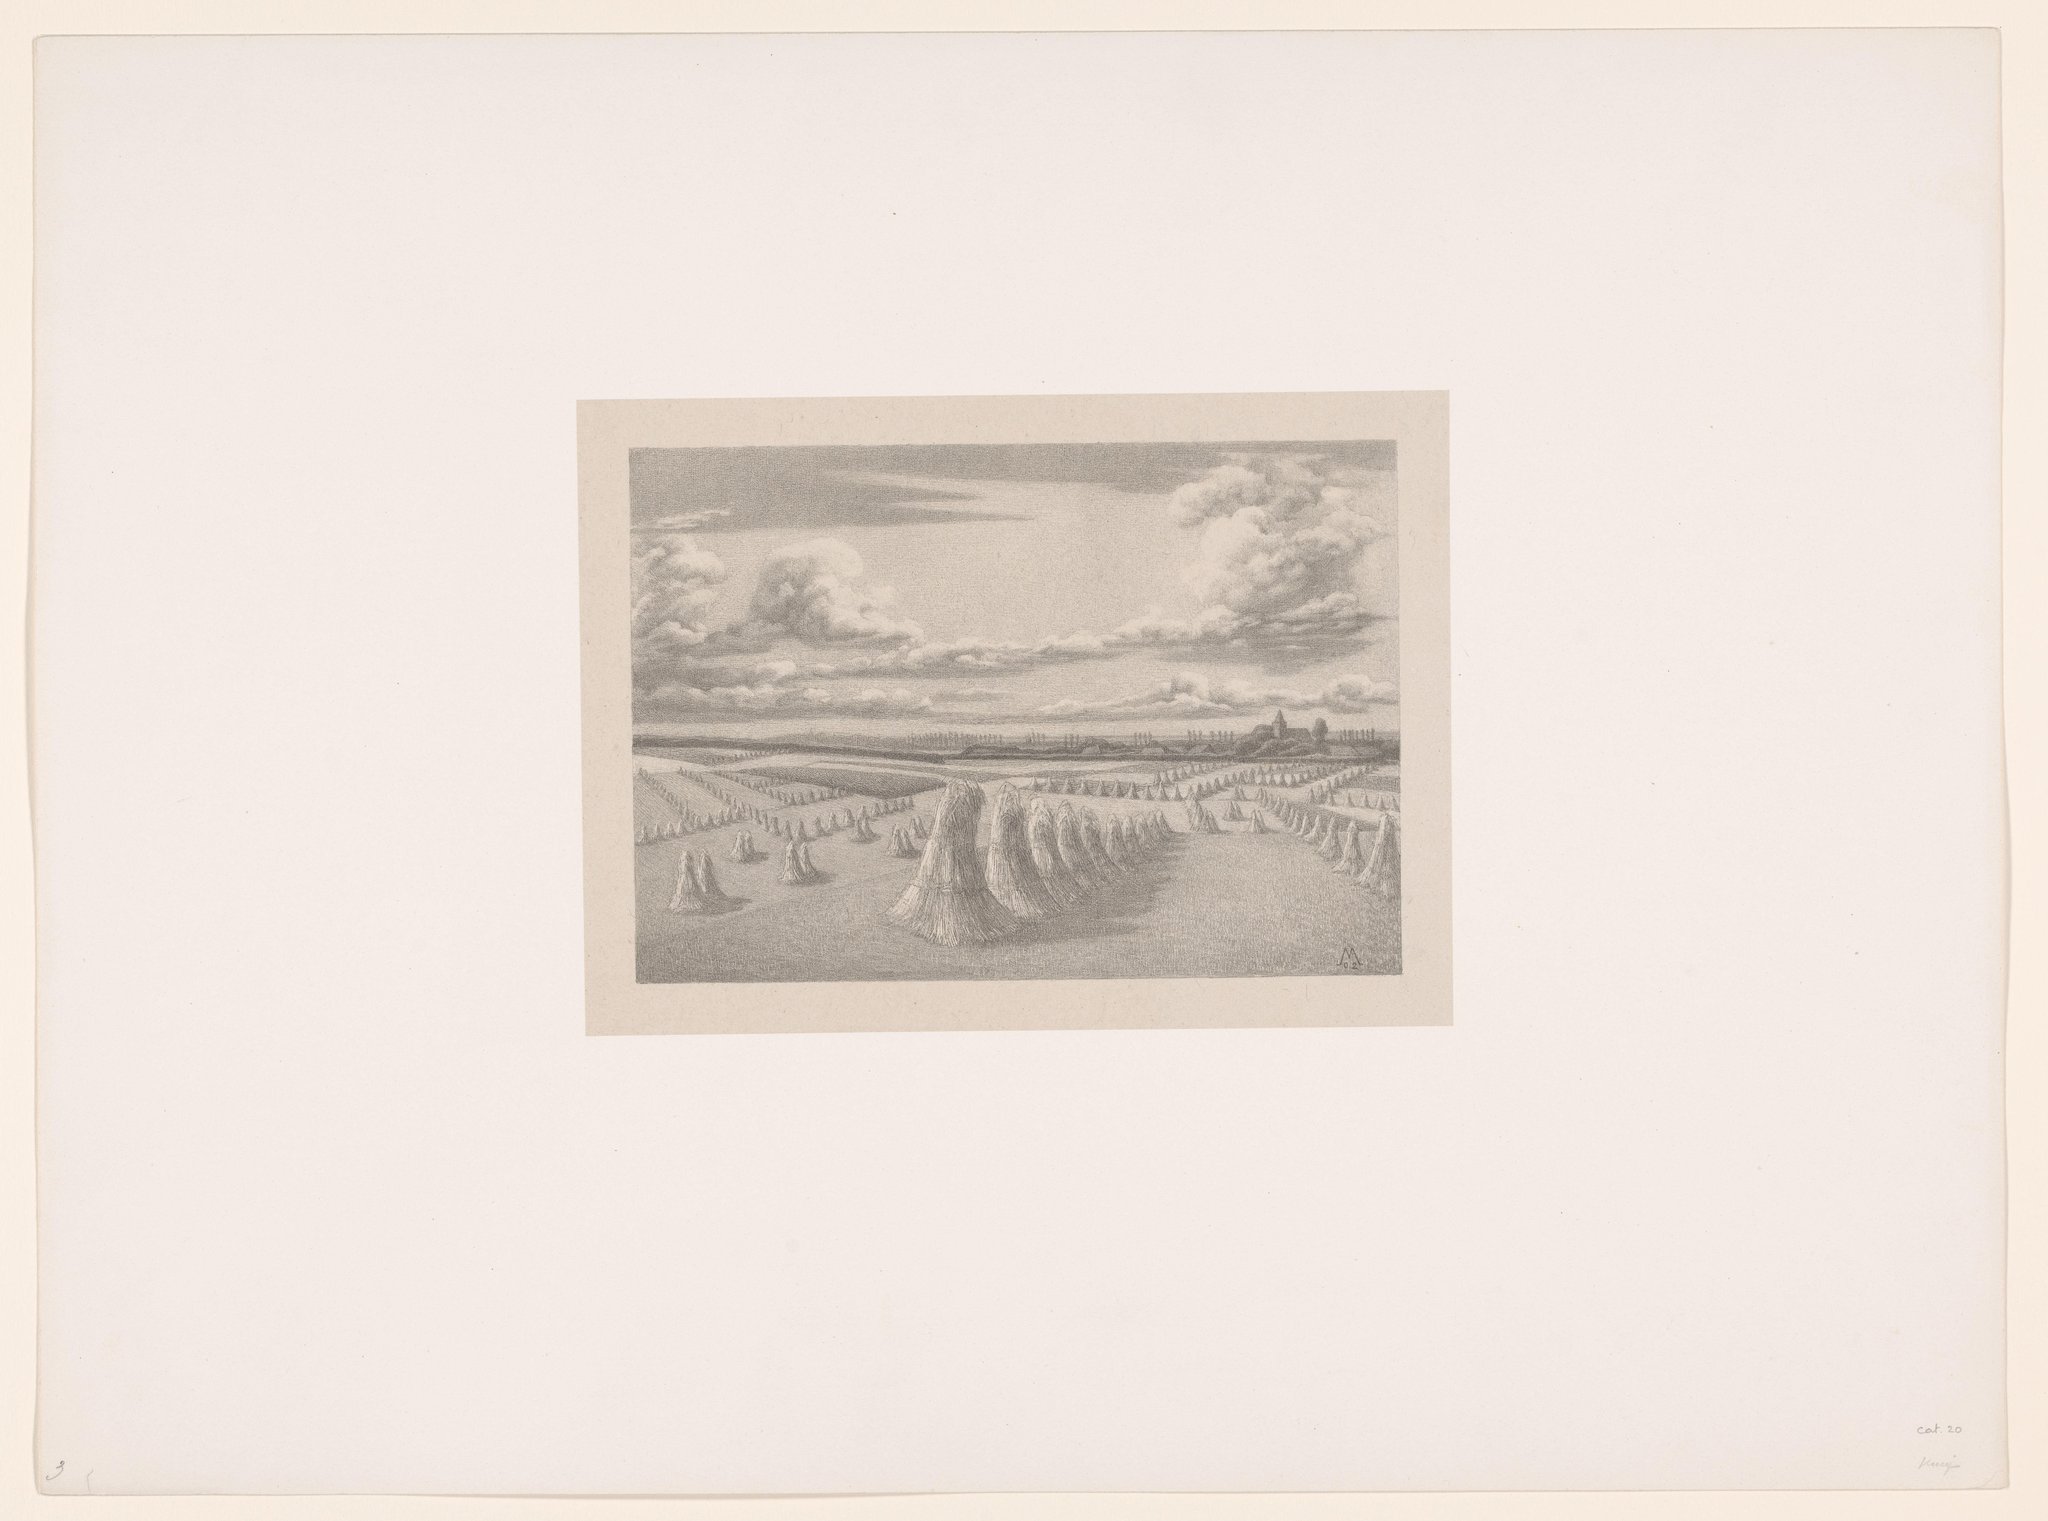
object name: print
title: Zomer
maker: simon moulijn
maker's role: draughtsman, print maker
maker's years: 1866-1948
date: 1902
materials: paper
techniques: lithograph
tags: prospect of village, silhouette of village, cultivated land, sheaf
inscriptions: collector's mark: Lugt 2228